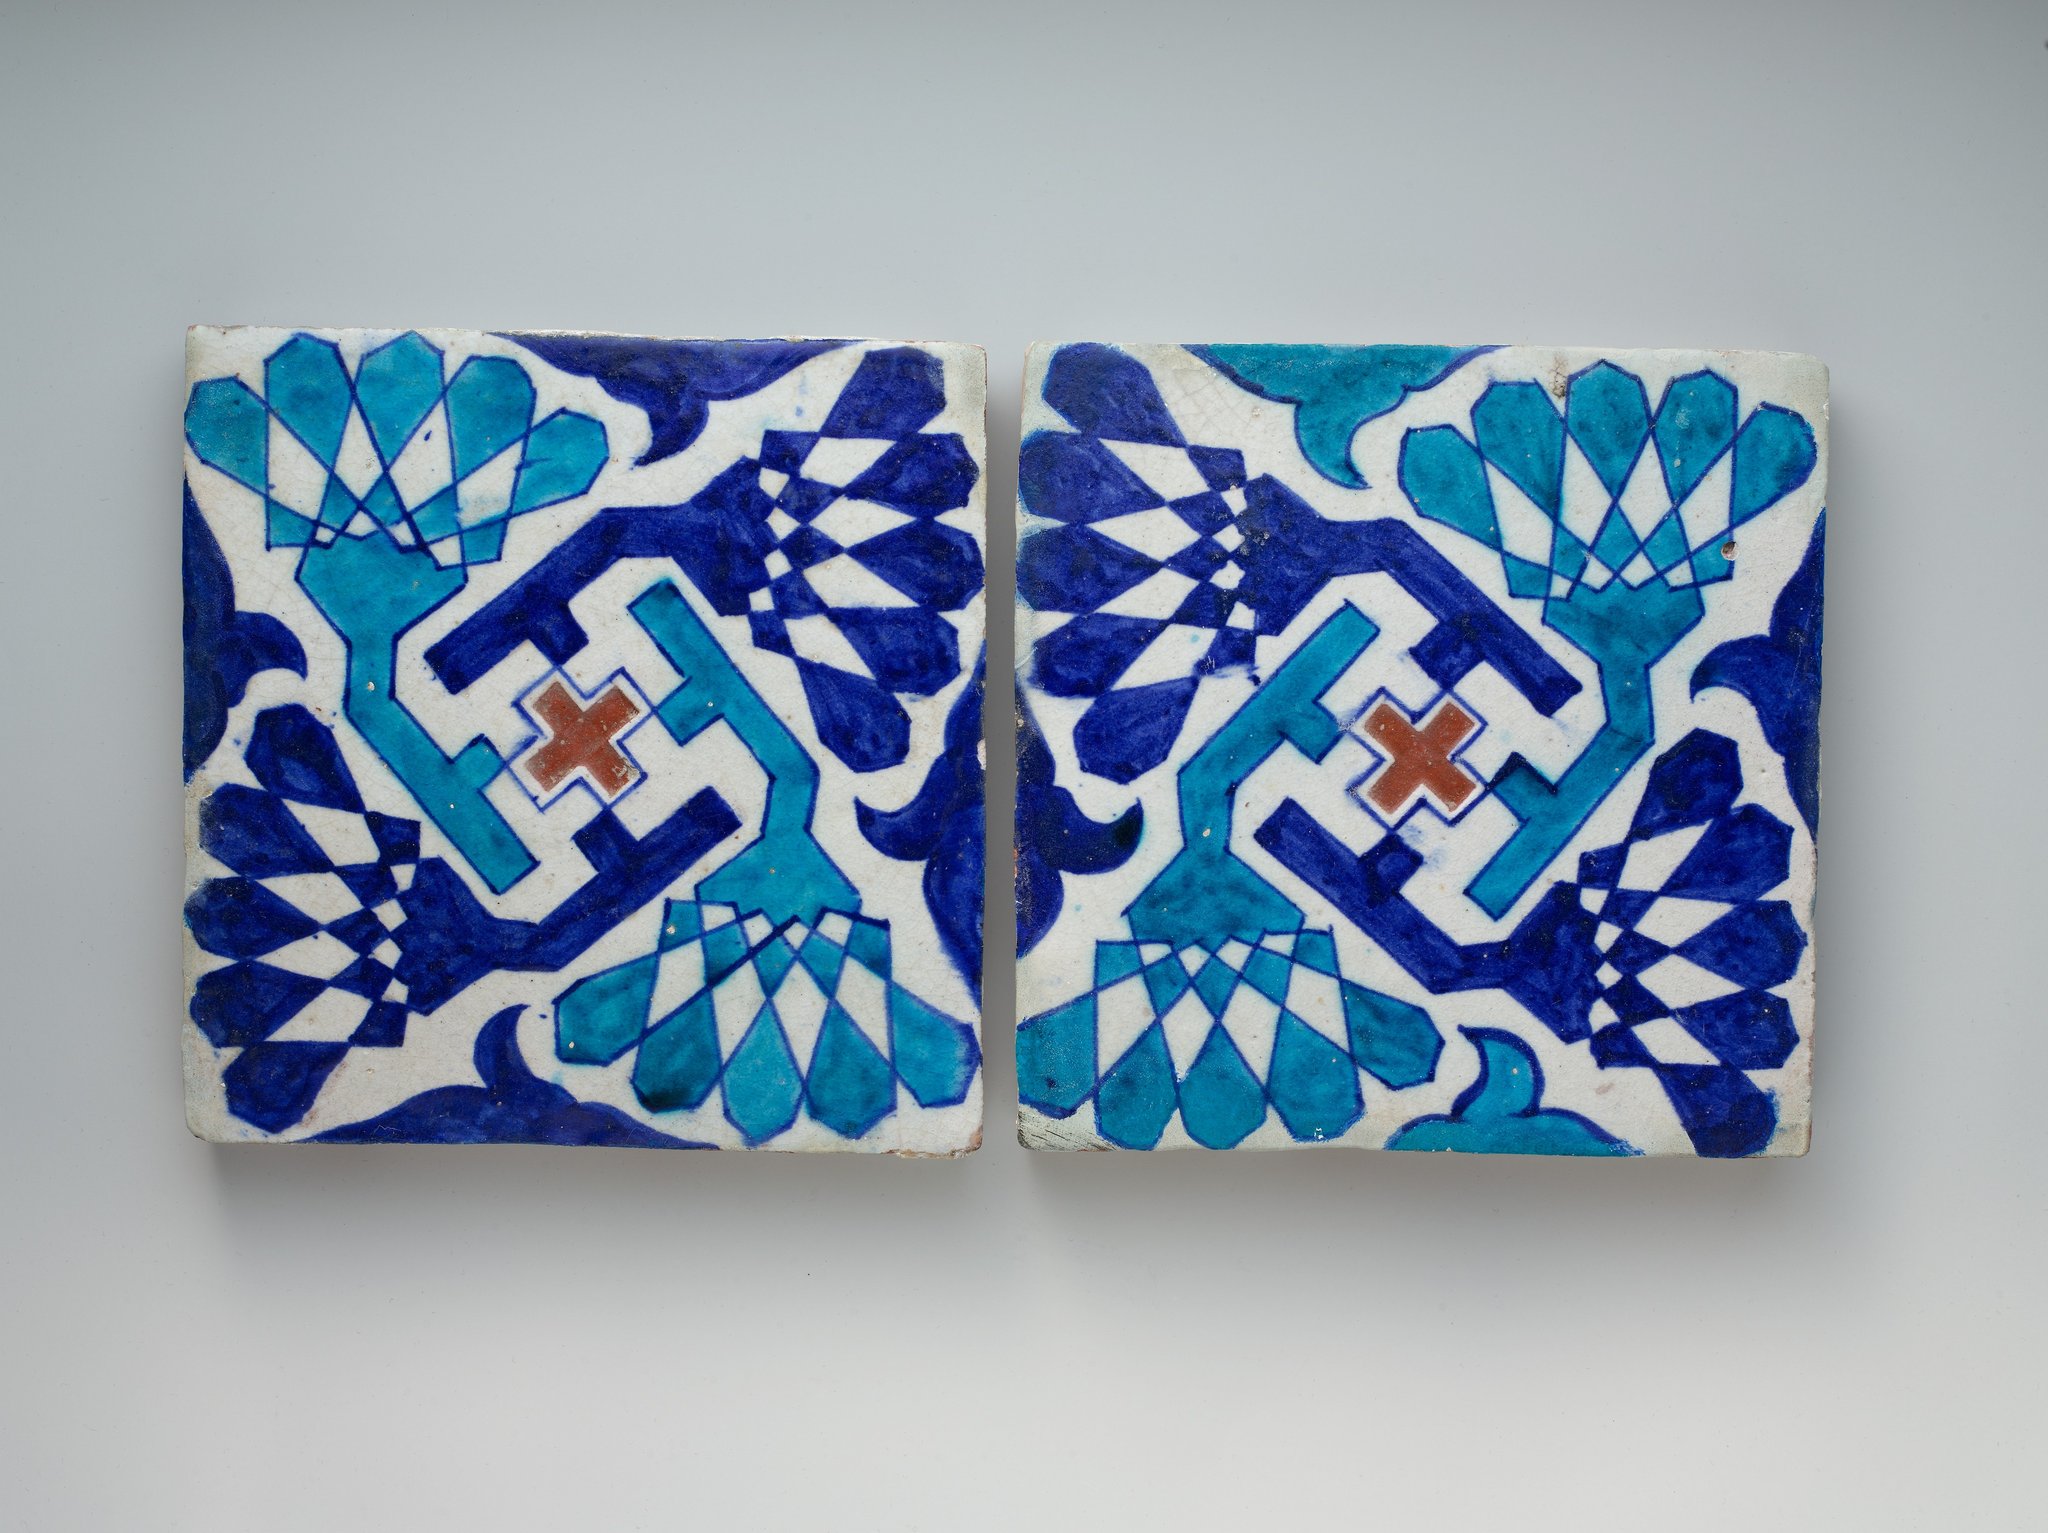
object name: tile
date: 1467-1500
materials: glaze, stonepaste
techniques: painting, polychrome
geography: pakistan